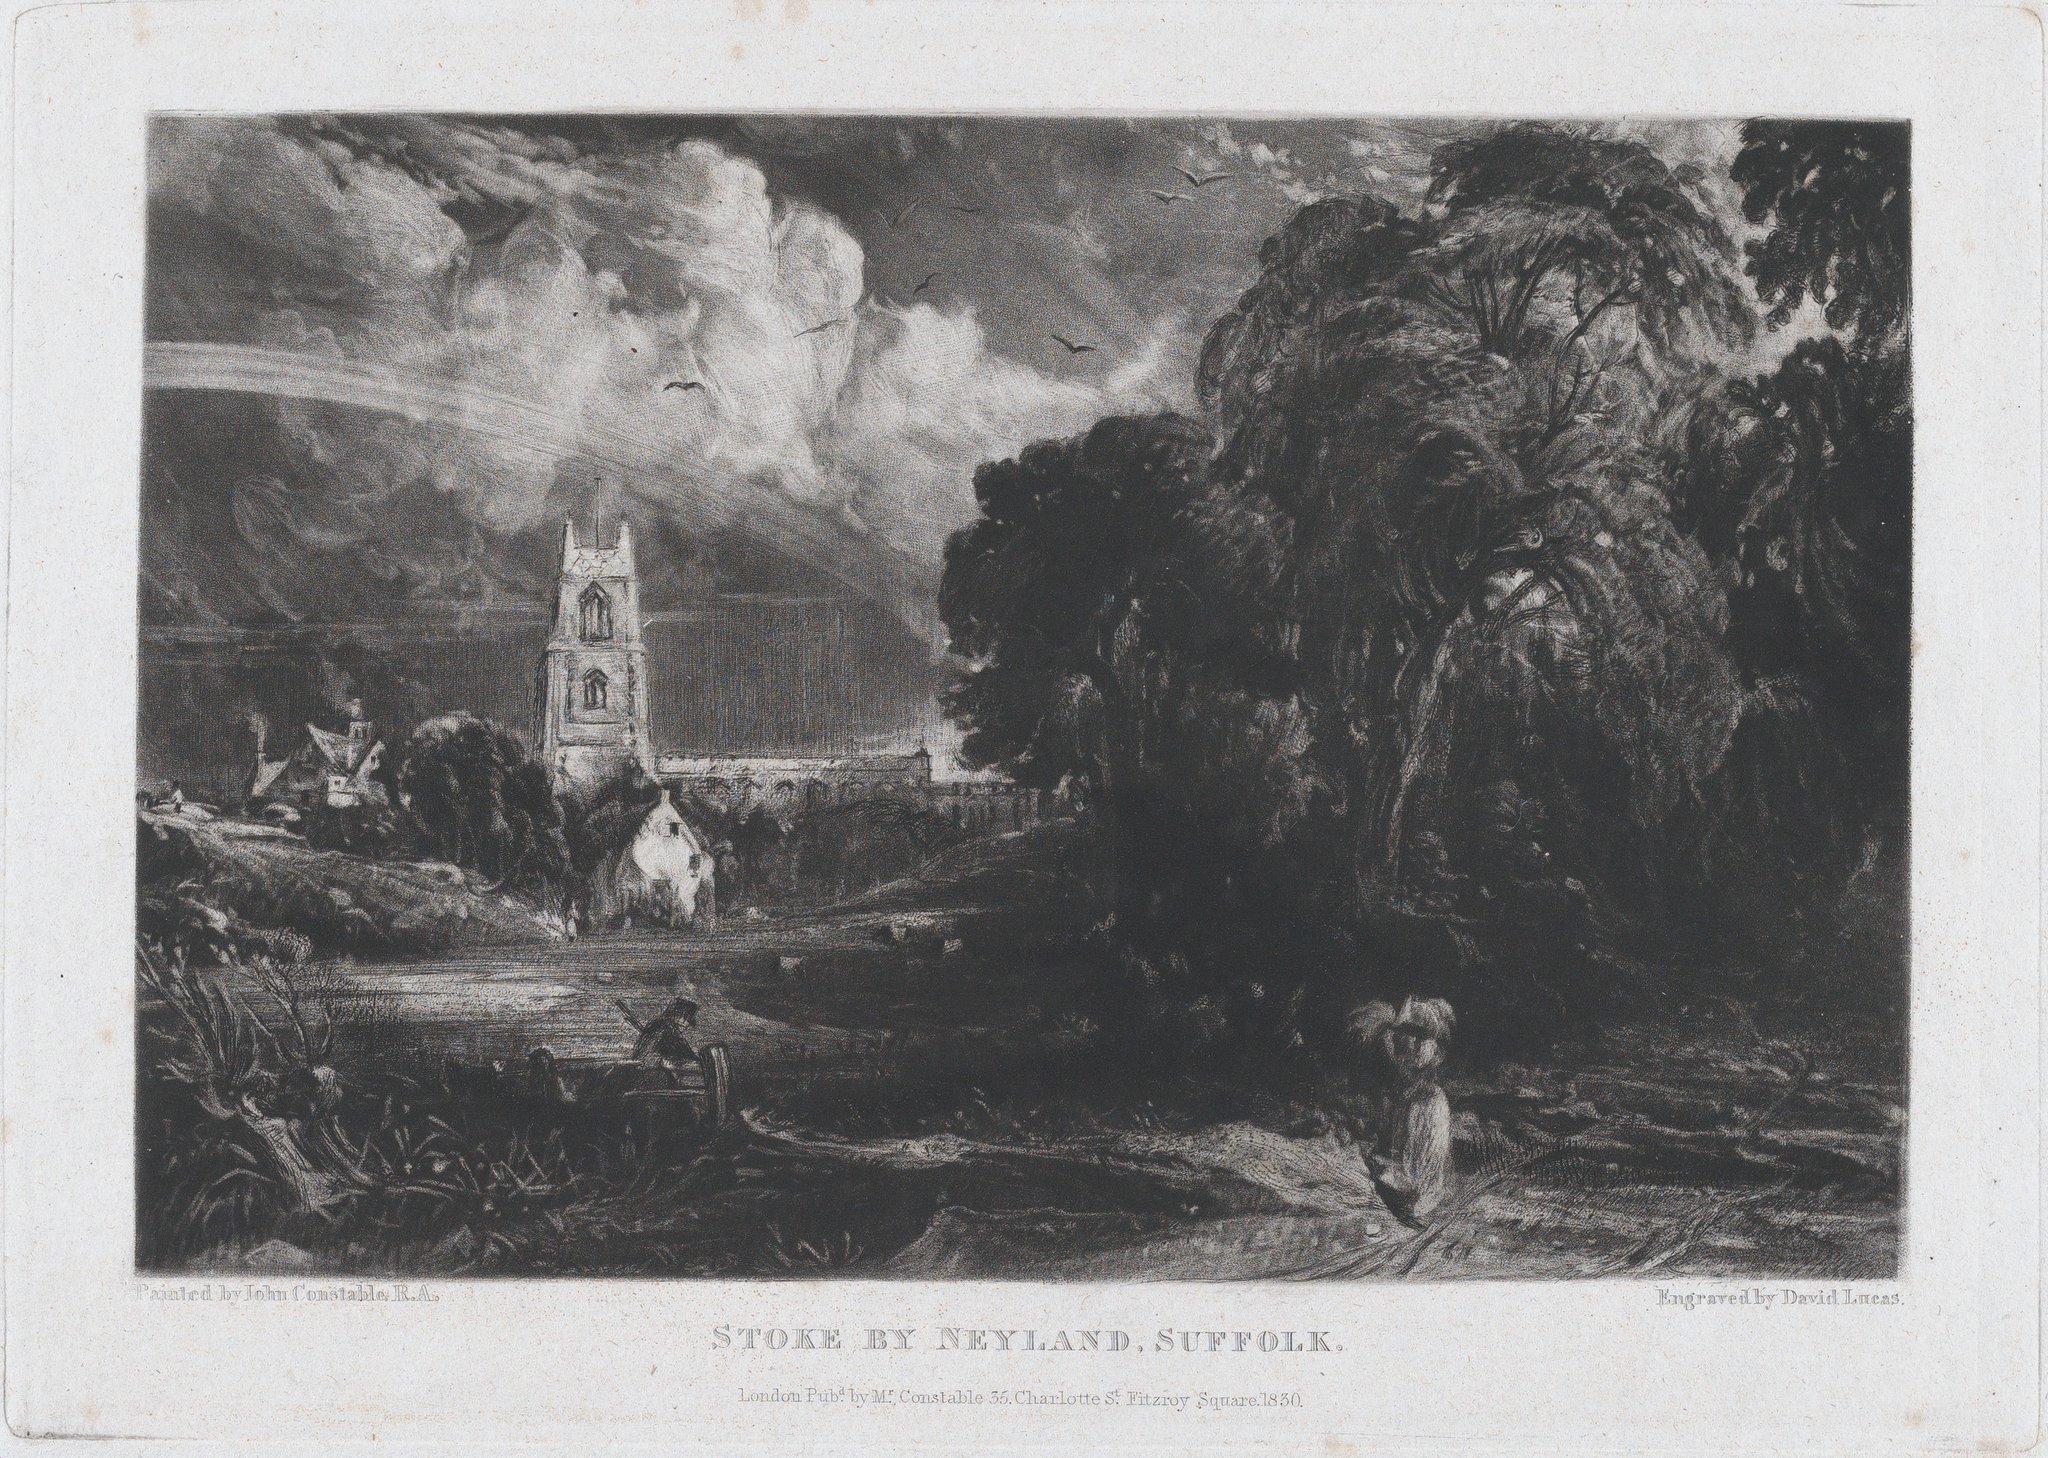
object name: print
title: Stoke-by-Neyland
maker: david lucas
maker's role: artist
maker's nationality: british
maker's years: 1802-1881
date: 1830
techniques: mezzotint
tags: towers,trees